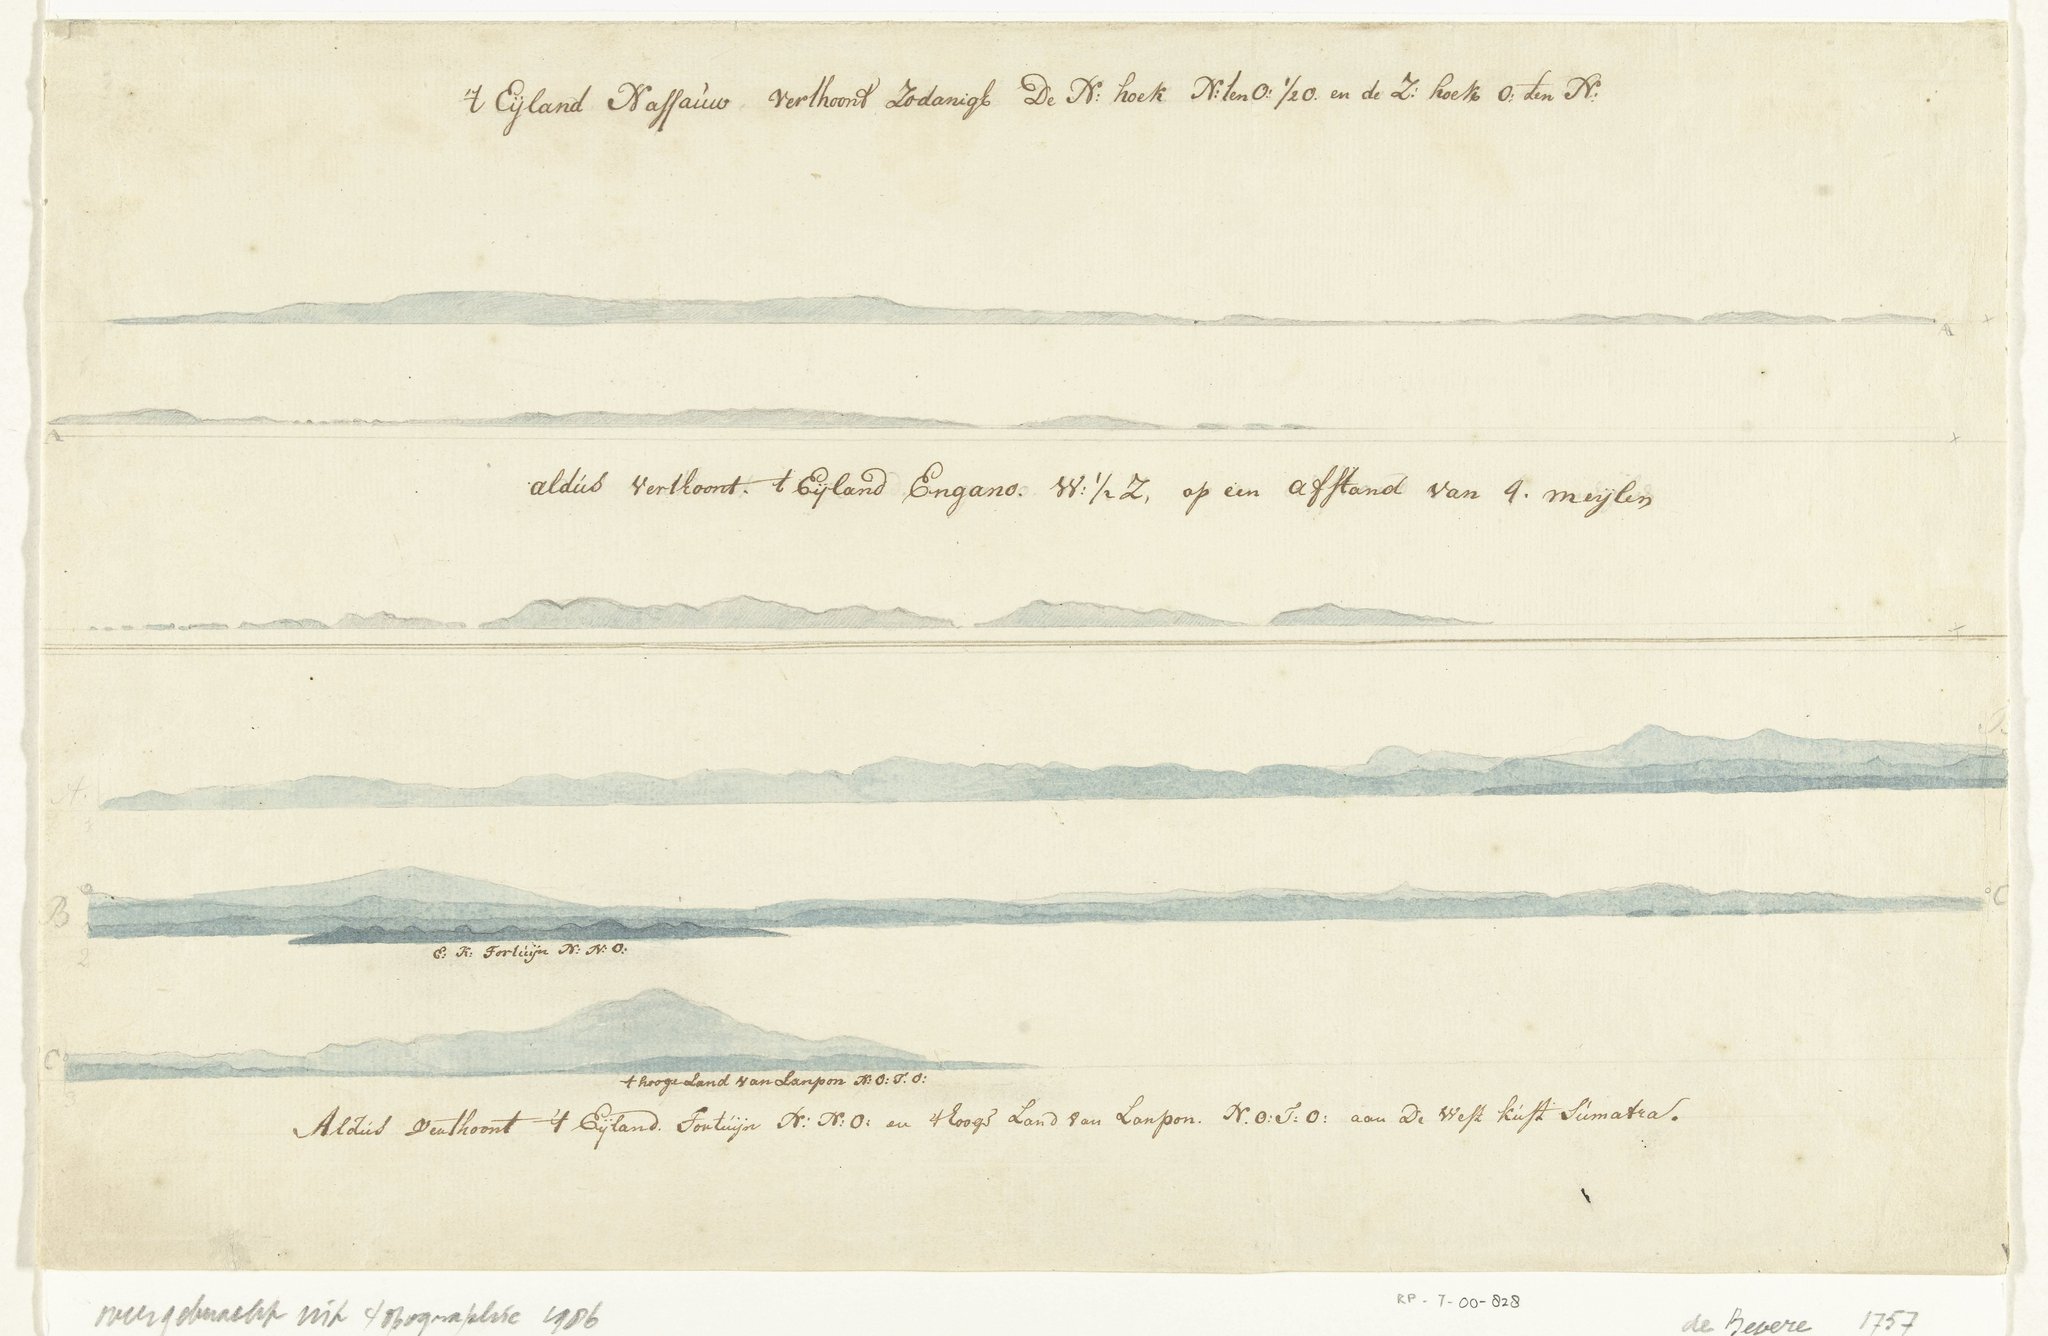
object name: drawing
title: Profielen van eilanden getekend op de reis van Ceylon naar Batavia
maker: pieter de bevere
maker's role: draughtsman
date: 1757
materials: graphite, ink, paper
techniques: brush, pen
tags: island, java, sumatra, indonesia